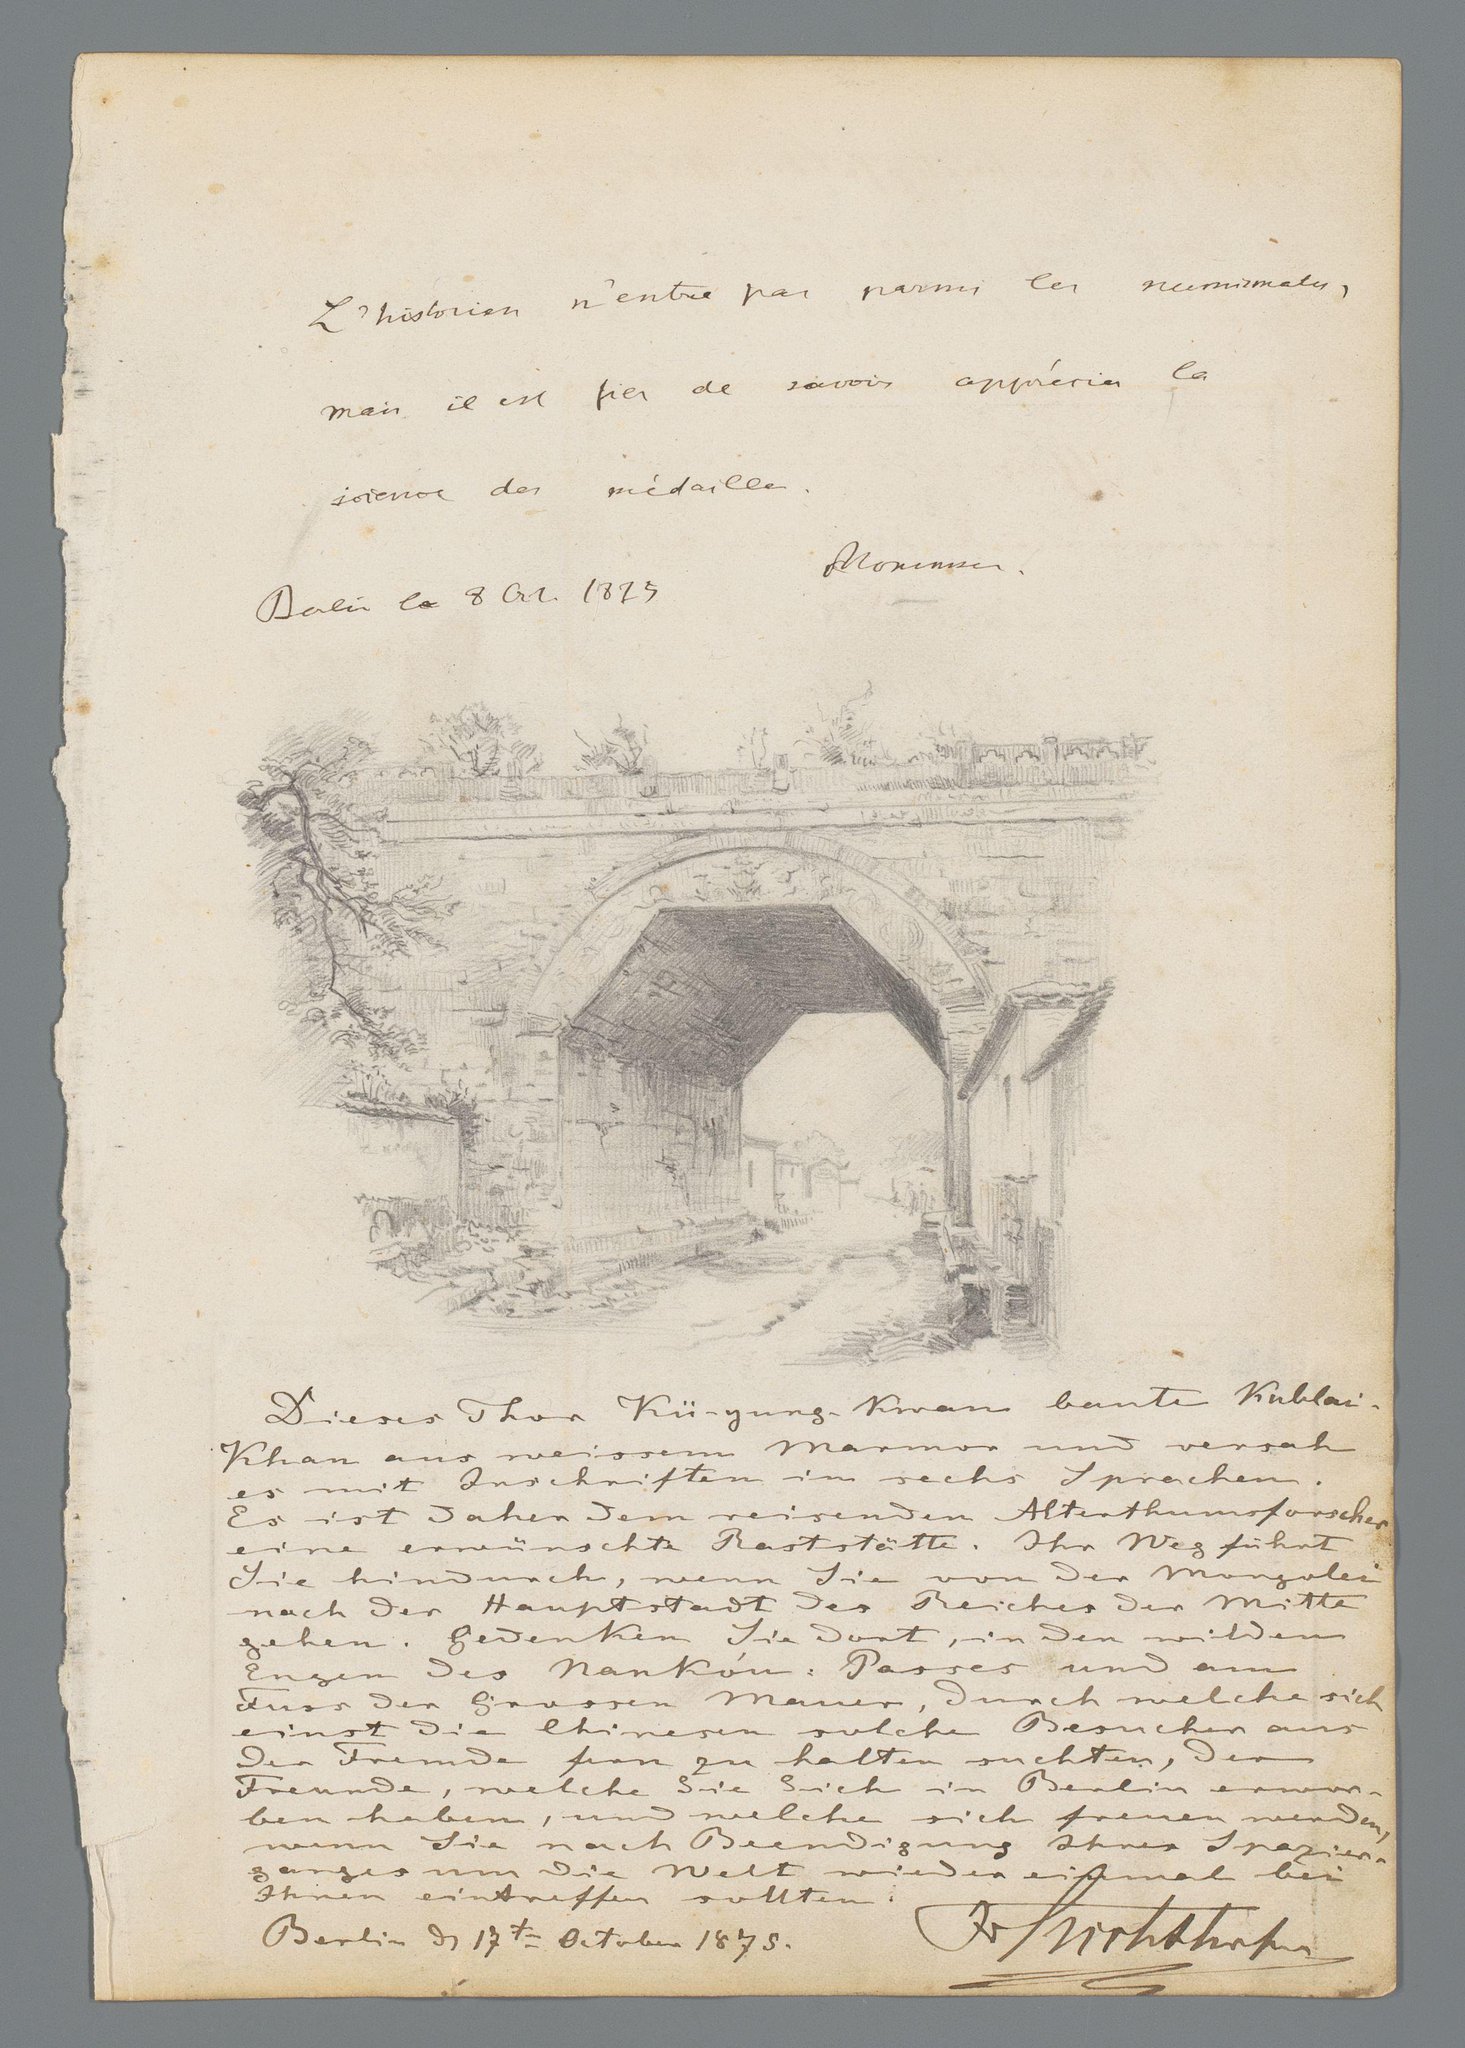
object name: drawing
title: Poort in China, gebouwd door Koeblai Khan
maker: Anonymous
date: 1875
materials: ink, paper, pencil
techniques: pen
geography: dresden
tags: gate, entrance, city-gate, china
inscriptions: inscription: ‘Dieses Thor Kü-yung-Kwam [?] baute Kublai/ Khan aus weissem Marmor (...) Ihnen eintreffen sollten./ Berlin d. 17ten October 1875. [...]’, inscription: ‘L'historien n'entre pas parmi les numinales,/ mais il est fier de savoir apprécier la/ science des médailles./ Berlin la 8 Oct. 1875 [...]’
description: Deze tekening maakte deel uit van een liber amicorum.